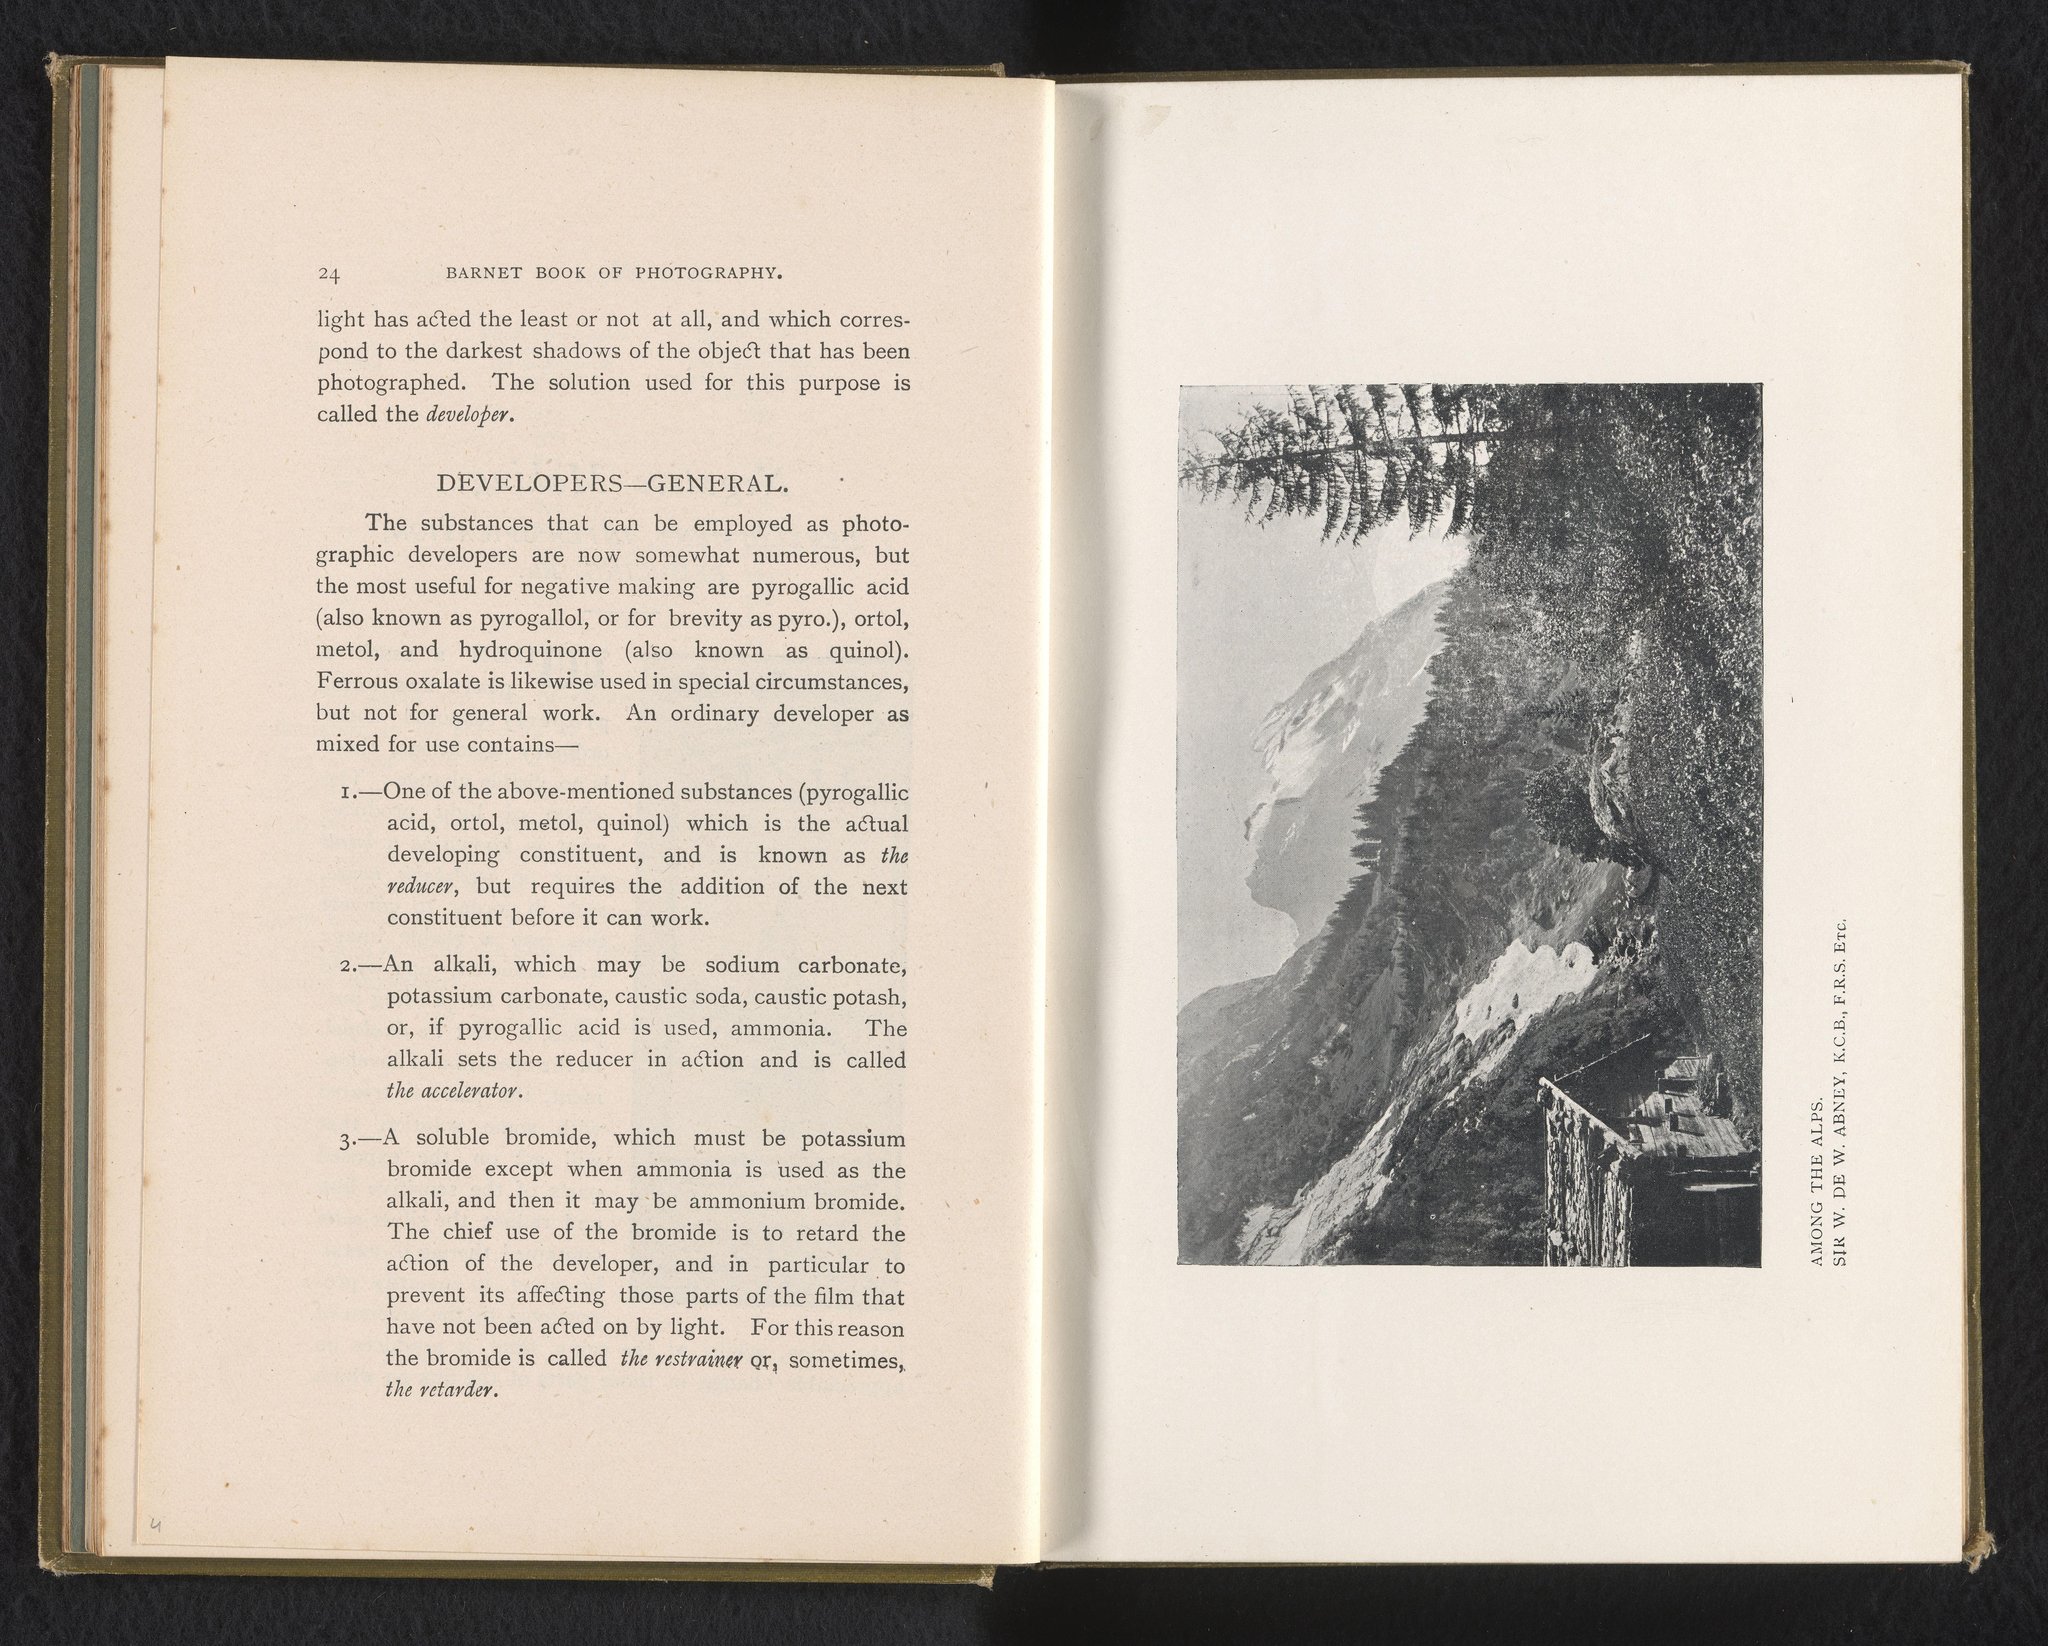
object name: photomechanical print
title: Among the Alps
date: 1895-1900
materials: paper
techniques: autotype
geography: united kingdom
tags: mountain-range, snow peaks, mountain meadow, alp